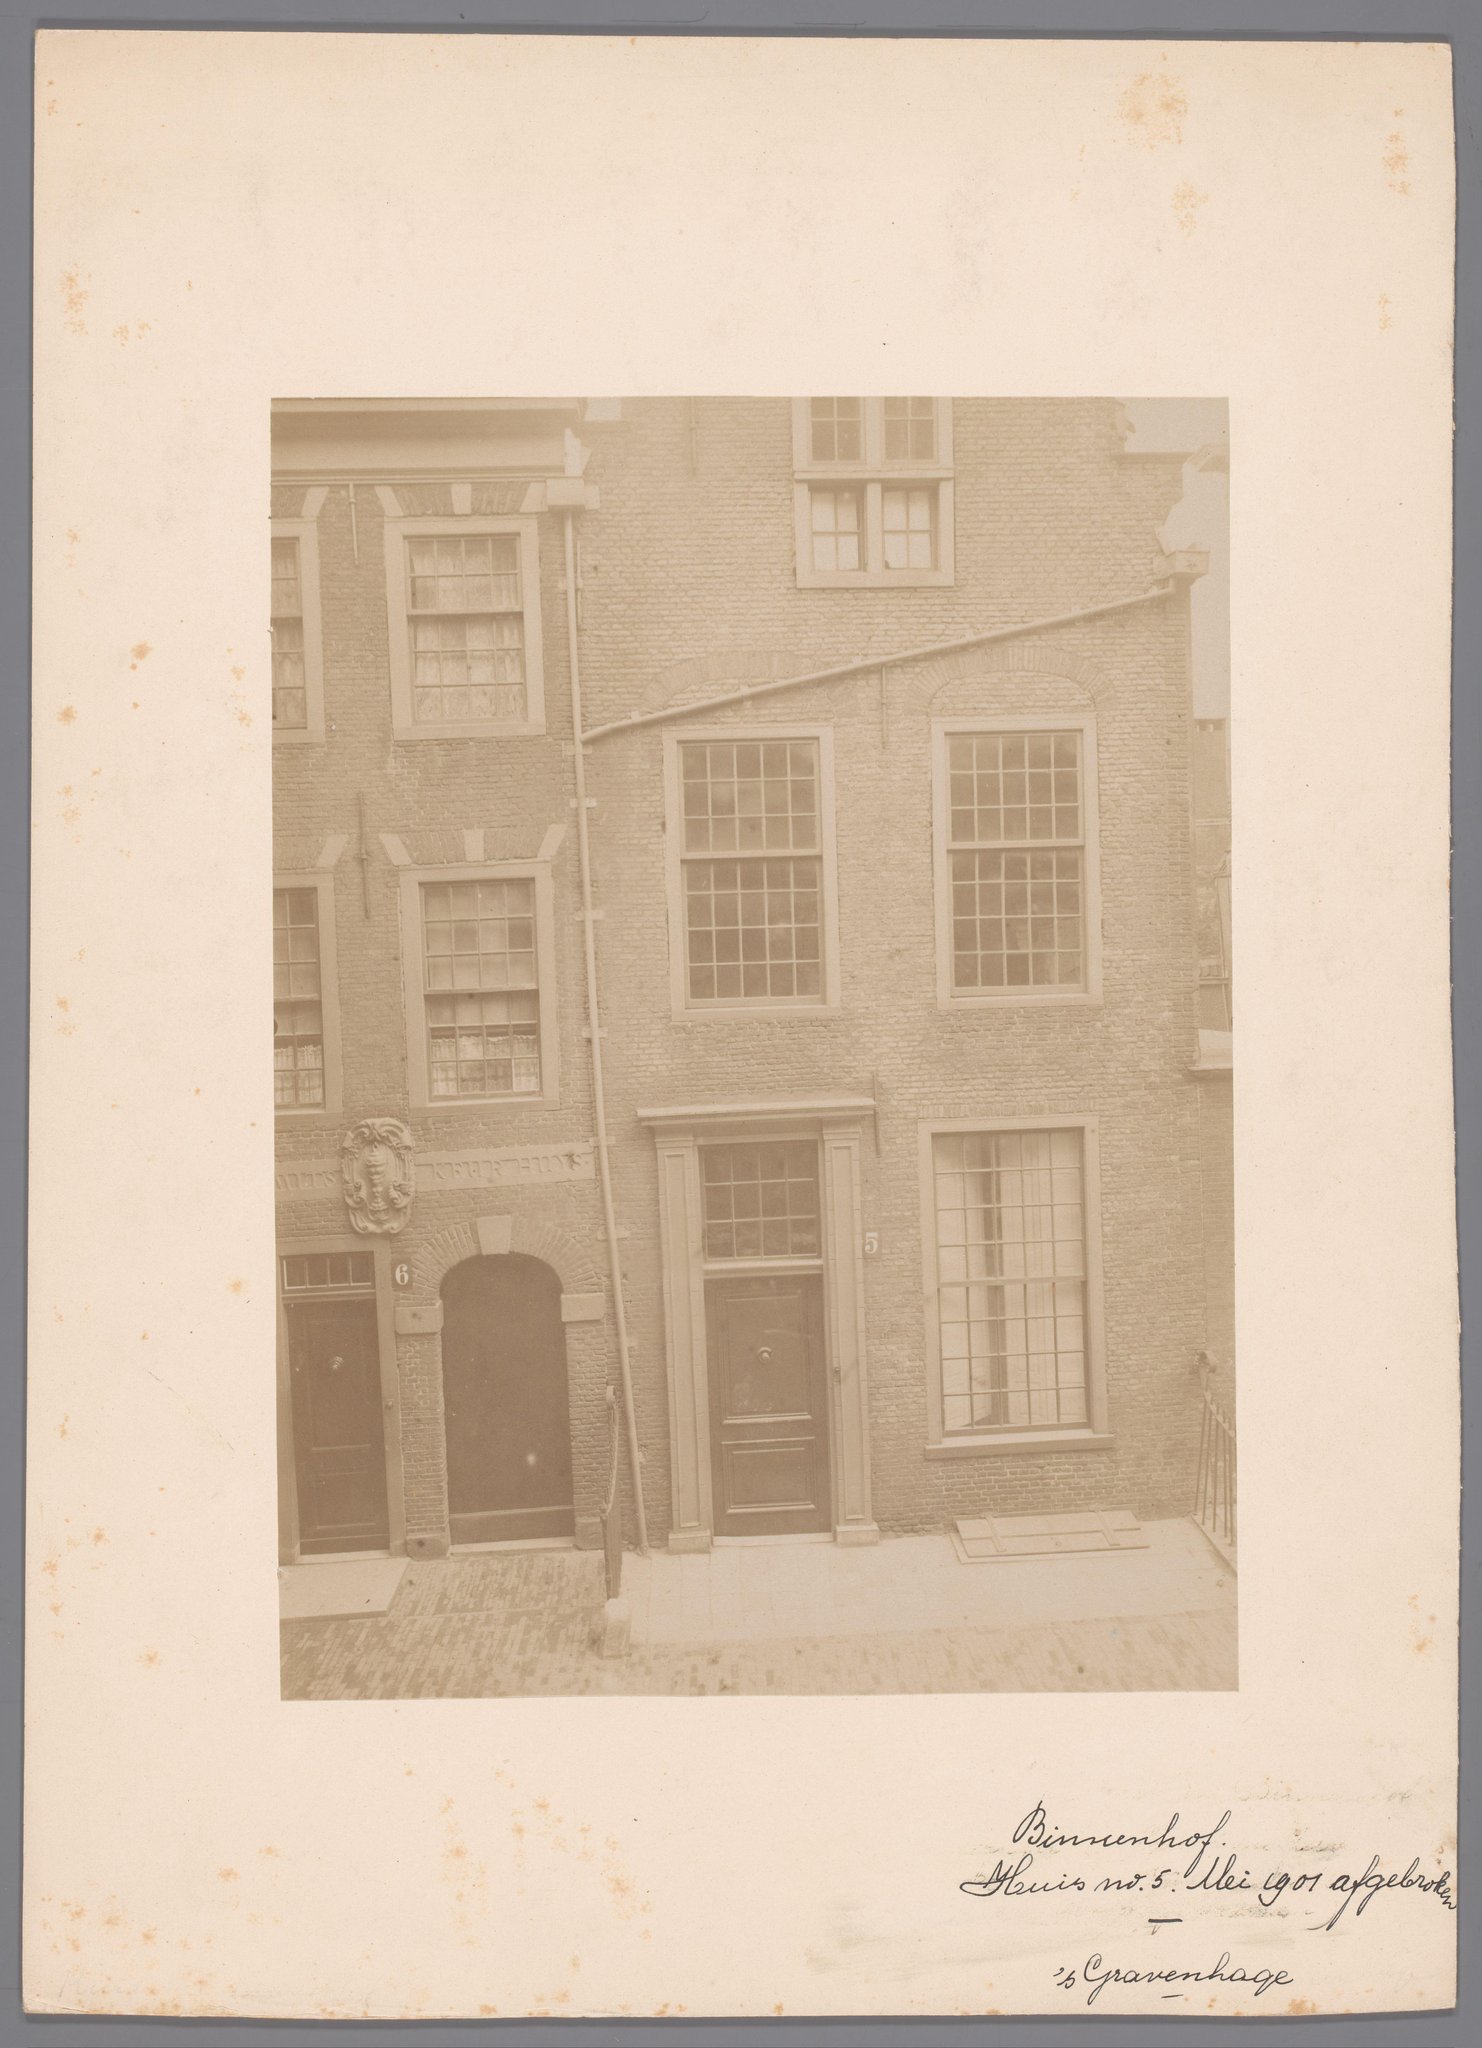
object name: photograph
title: Façade van Binnenhof 5 te Den Haag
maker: anoniem (monumentenzorg)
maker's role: fotograaf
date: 1895-1901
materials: cardboard, photographic support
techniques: albumen print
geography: binnenhof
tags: façade (of house or building)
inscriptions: annotation: ‘Binnenhof/ Huis no.5. Mei 1901 afgebroken/ 's Gravenhage’, annotation: ‘Huis N: 5 Binnehof 's Gravenhage (Z.H./ Mei 1901 afgebroken’